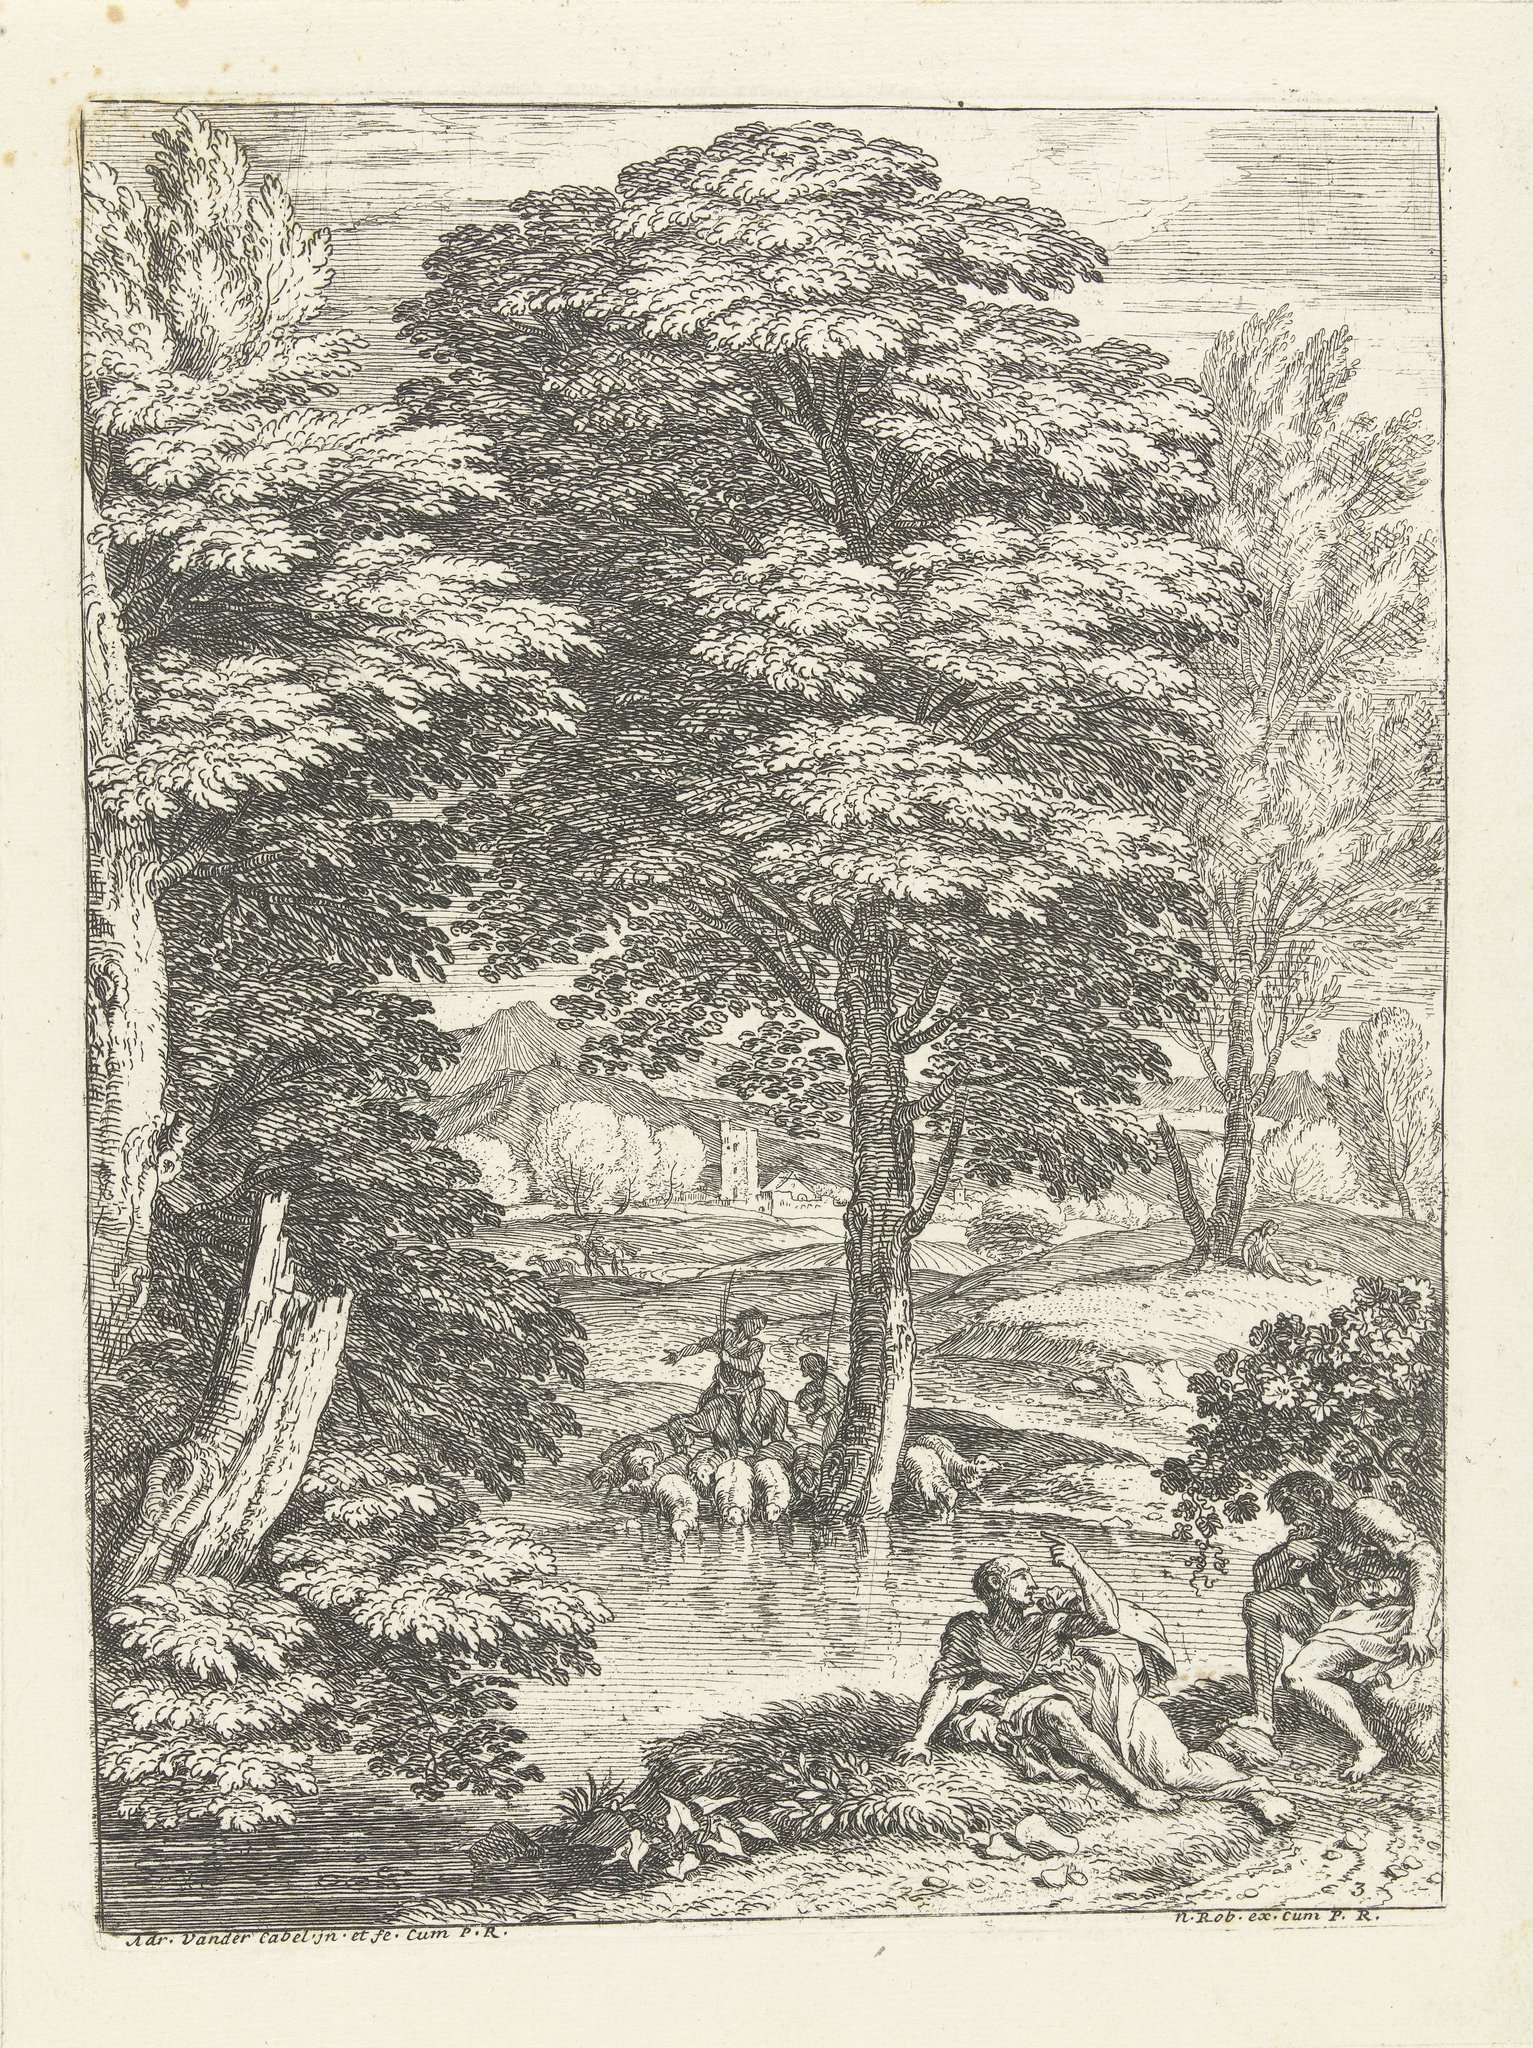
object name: print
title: Landschappen met schaapsherders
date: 1648-1705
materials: paper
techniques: etching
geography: france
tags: landscapes, herding, herdsman, herdswoman, shepherd, shepherdess, cowherd, etc.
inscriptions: collector's mark: Lugt 240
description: Landschap met op de voorgrond twee mannen zittend aan de rand van een vijver; op de achtergrond twee personen bij een boom en een kudde drinkende schapen.